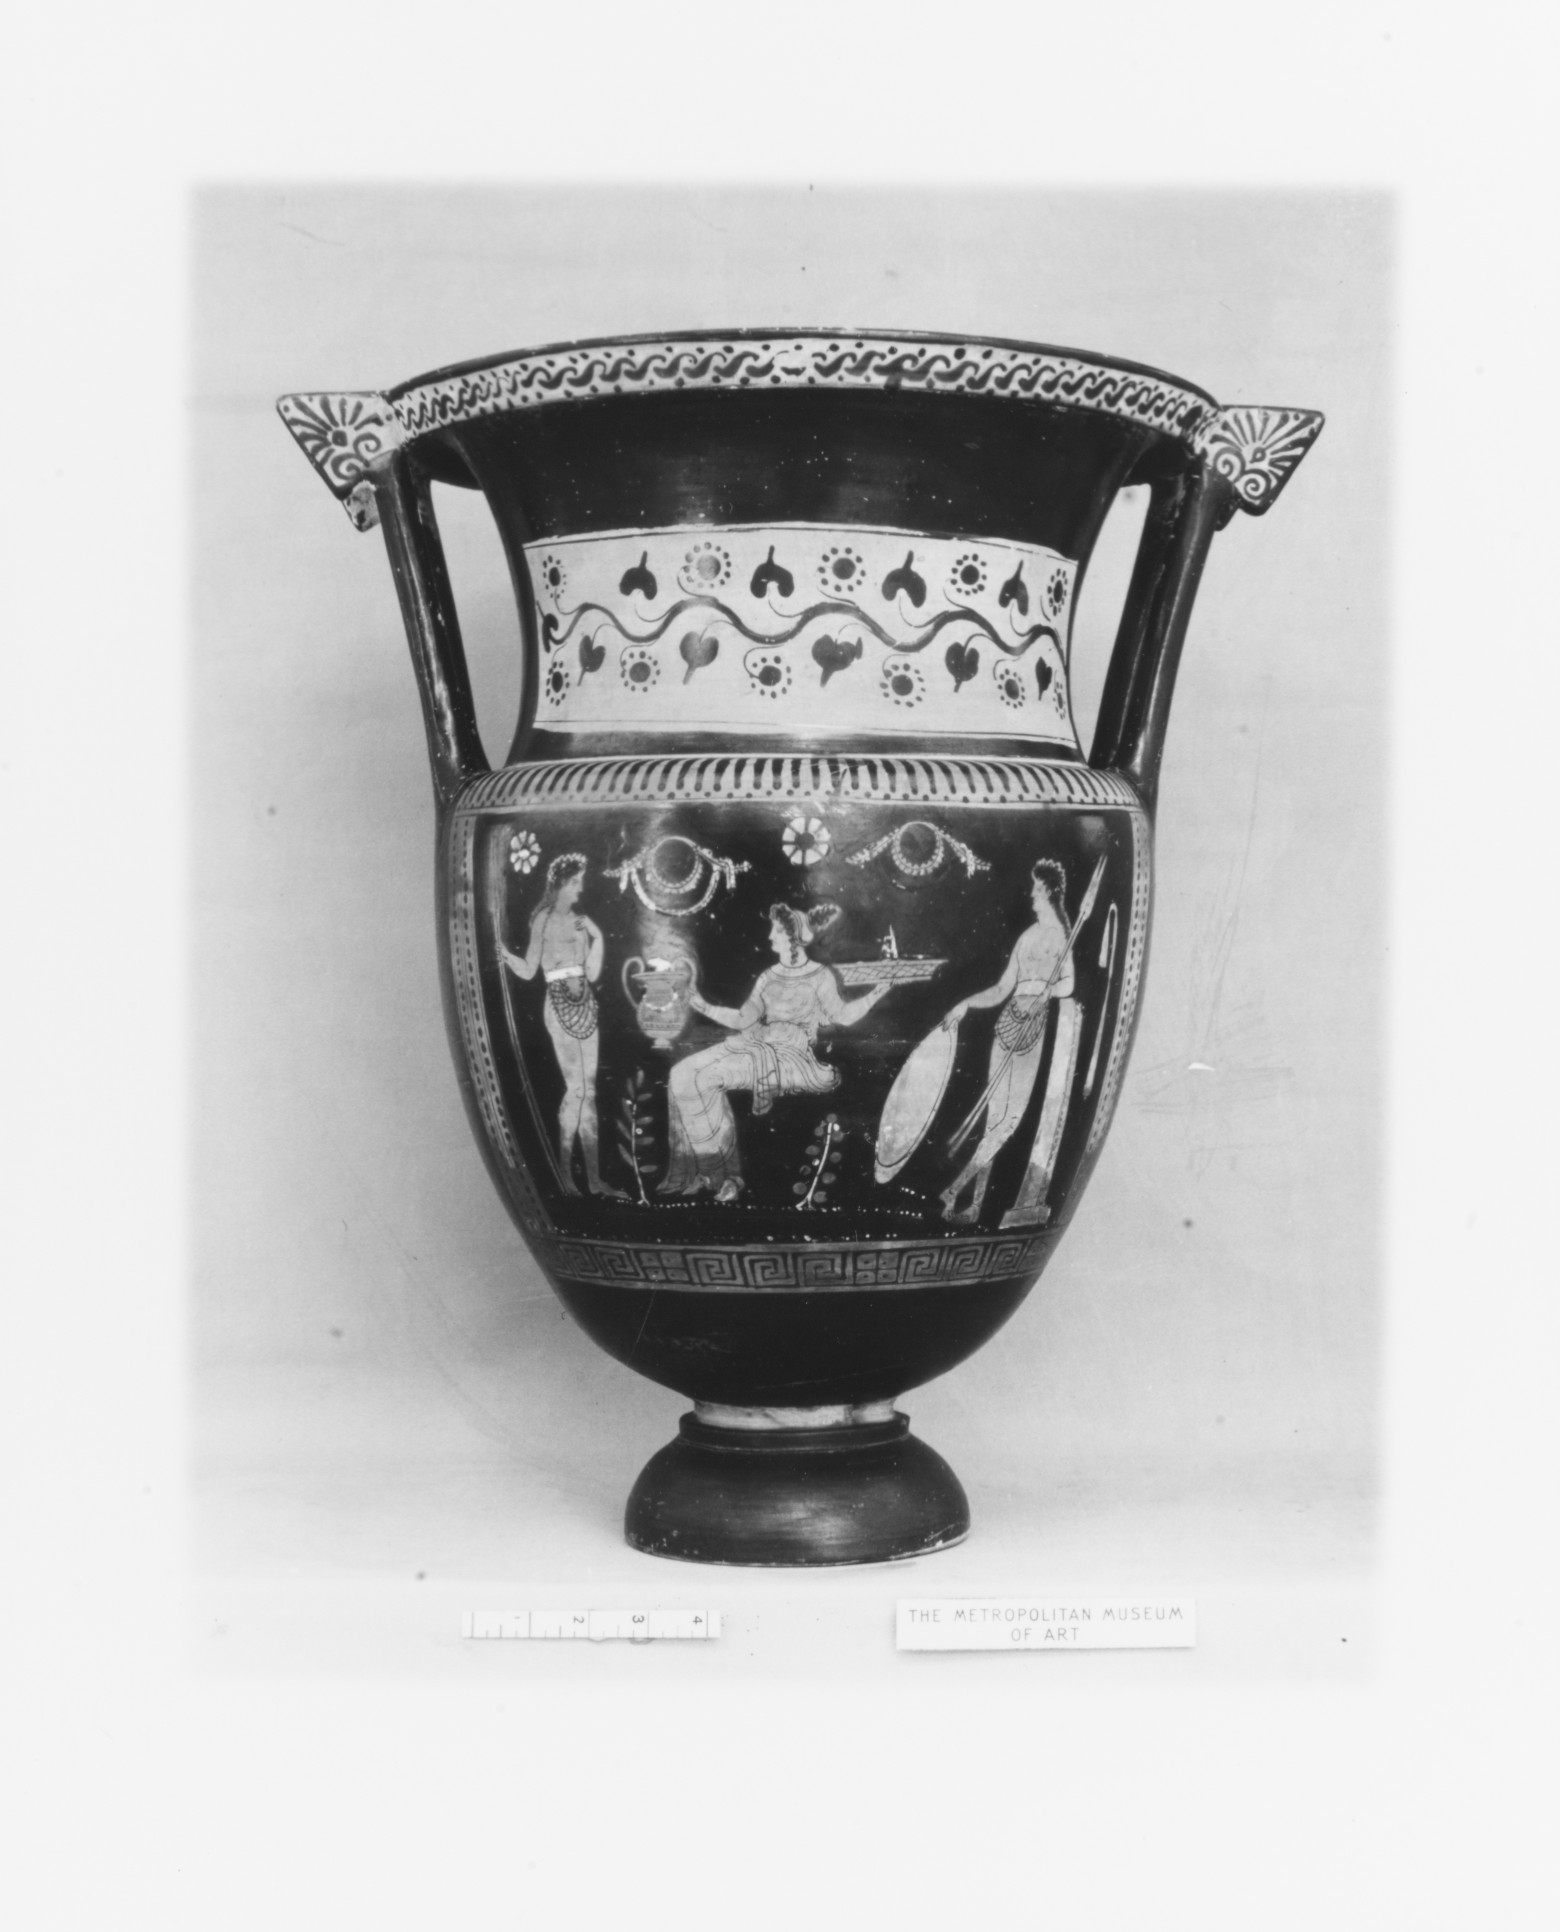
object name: column krater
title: Terracotta column-krater (mixing bowl)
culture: greek, south italian, apulian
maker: varrese painter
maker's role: artist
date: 360-340 BCE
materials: terracotta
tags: shields,spears,women